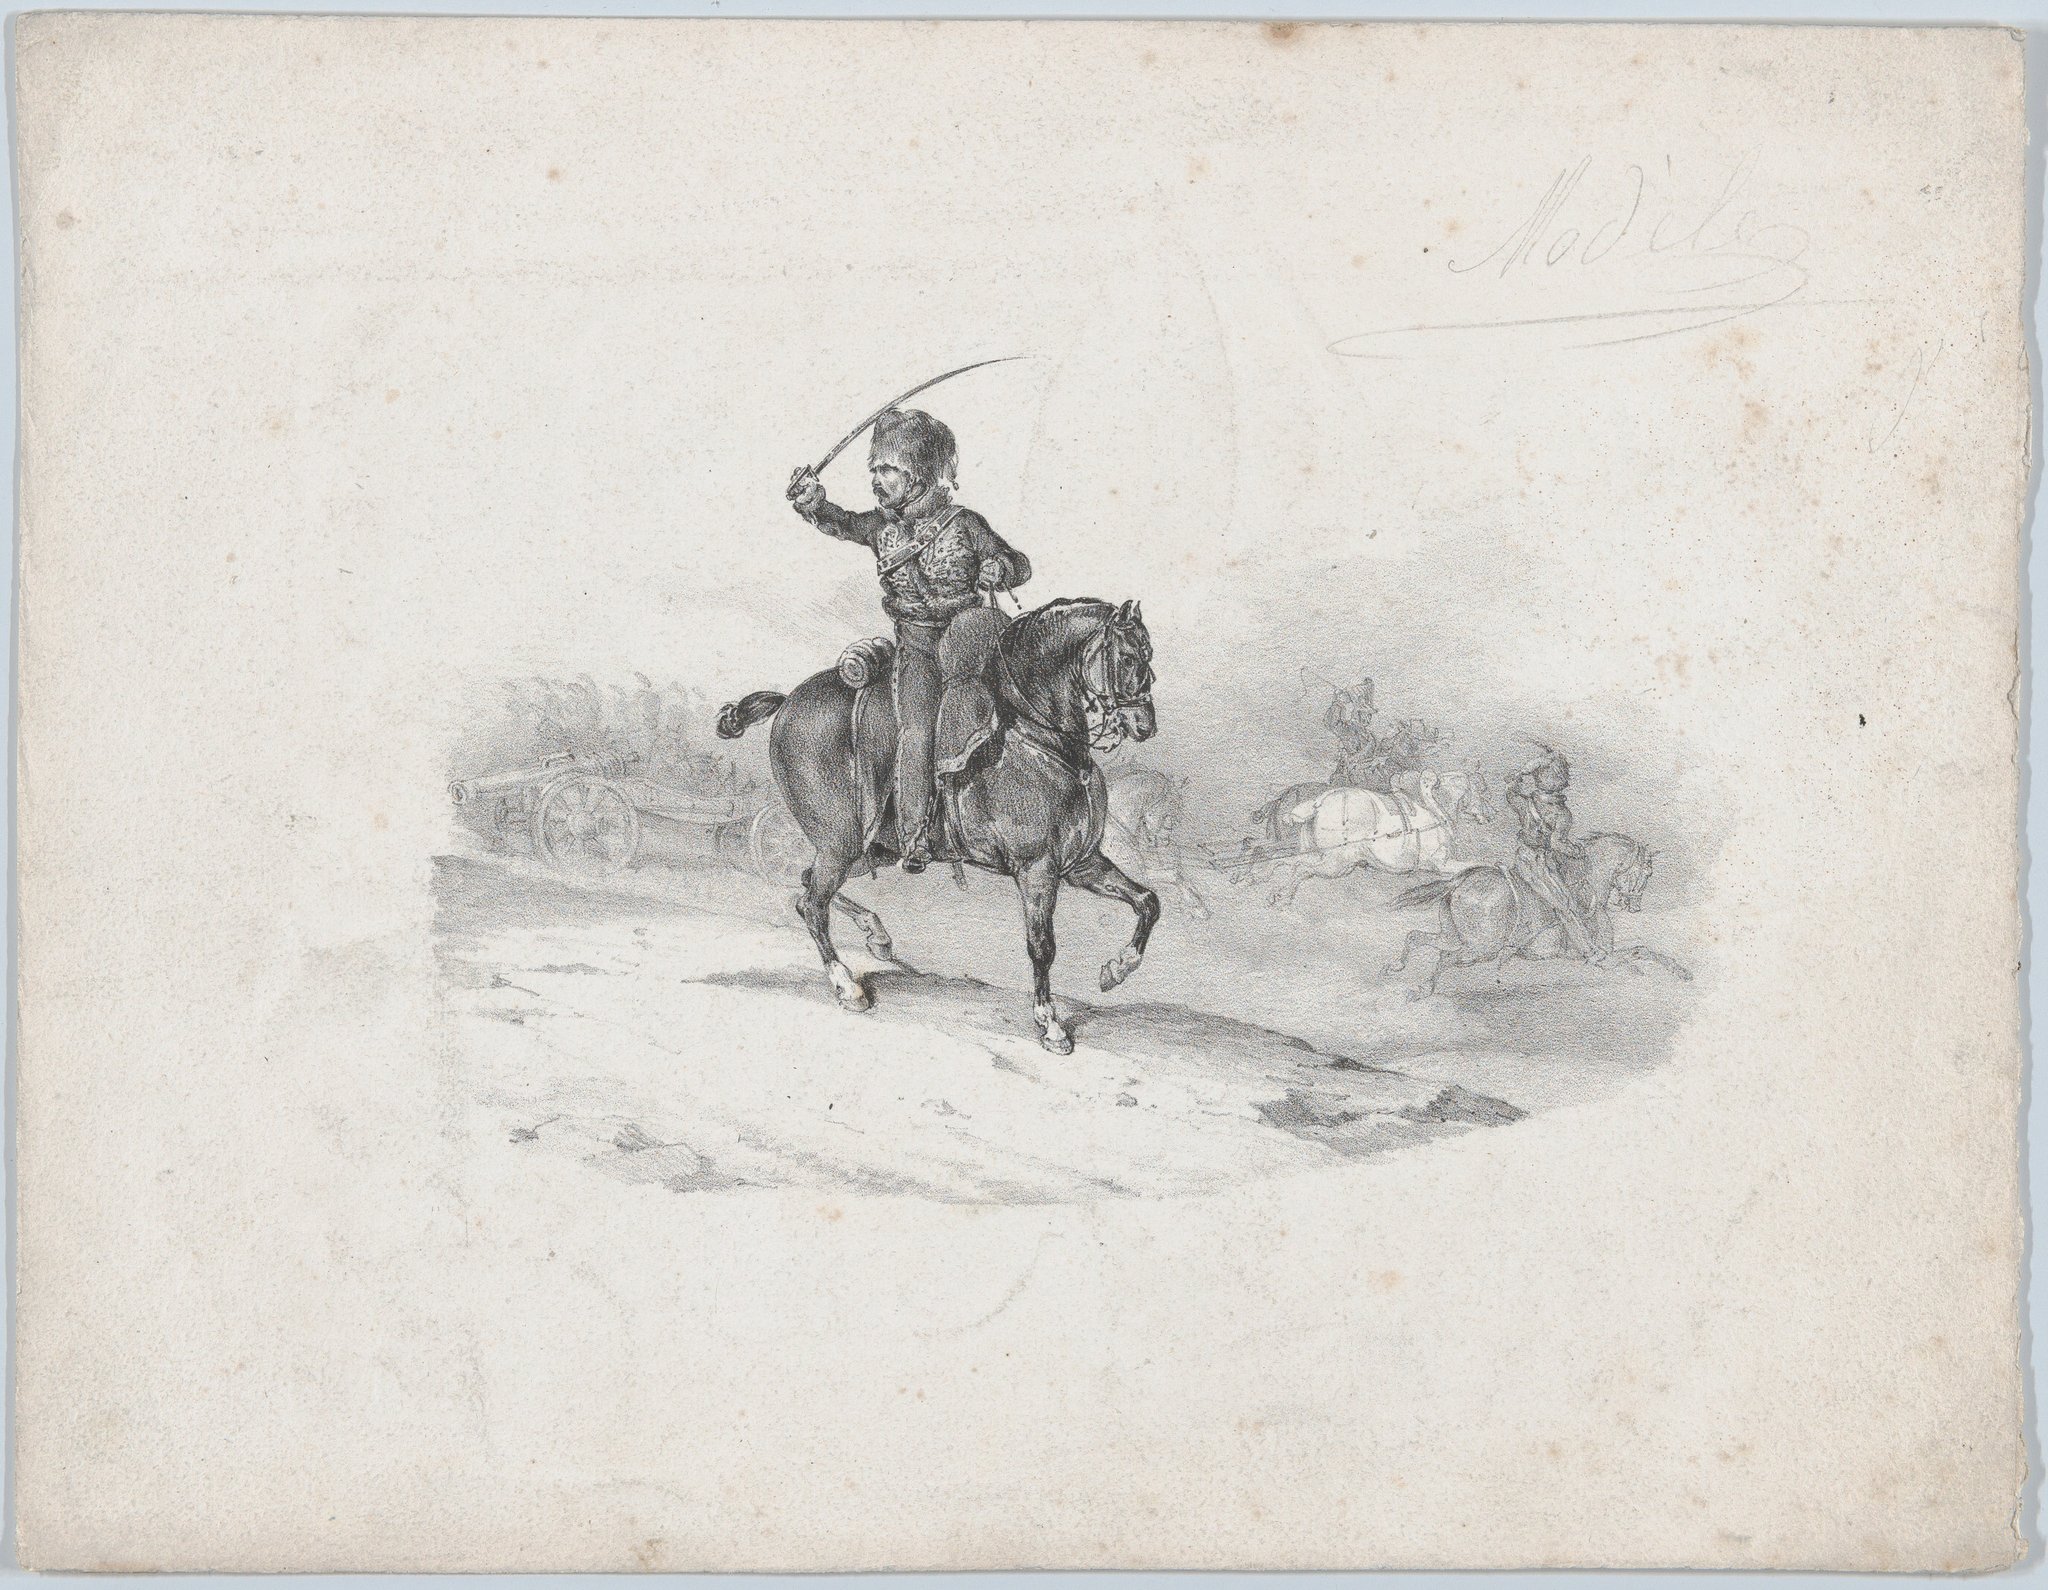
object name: print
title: Modèle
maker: jean louis andré théodore géricault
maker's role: artist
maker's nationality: french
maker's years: 1791-1824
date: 1800-1824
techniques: lithograph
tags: men,horses